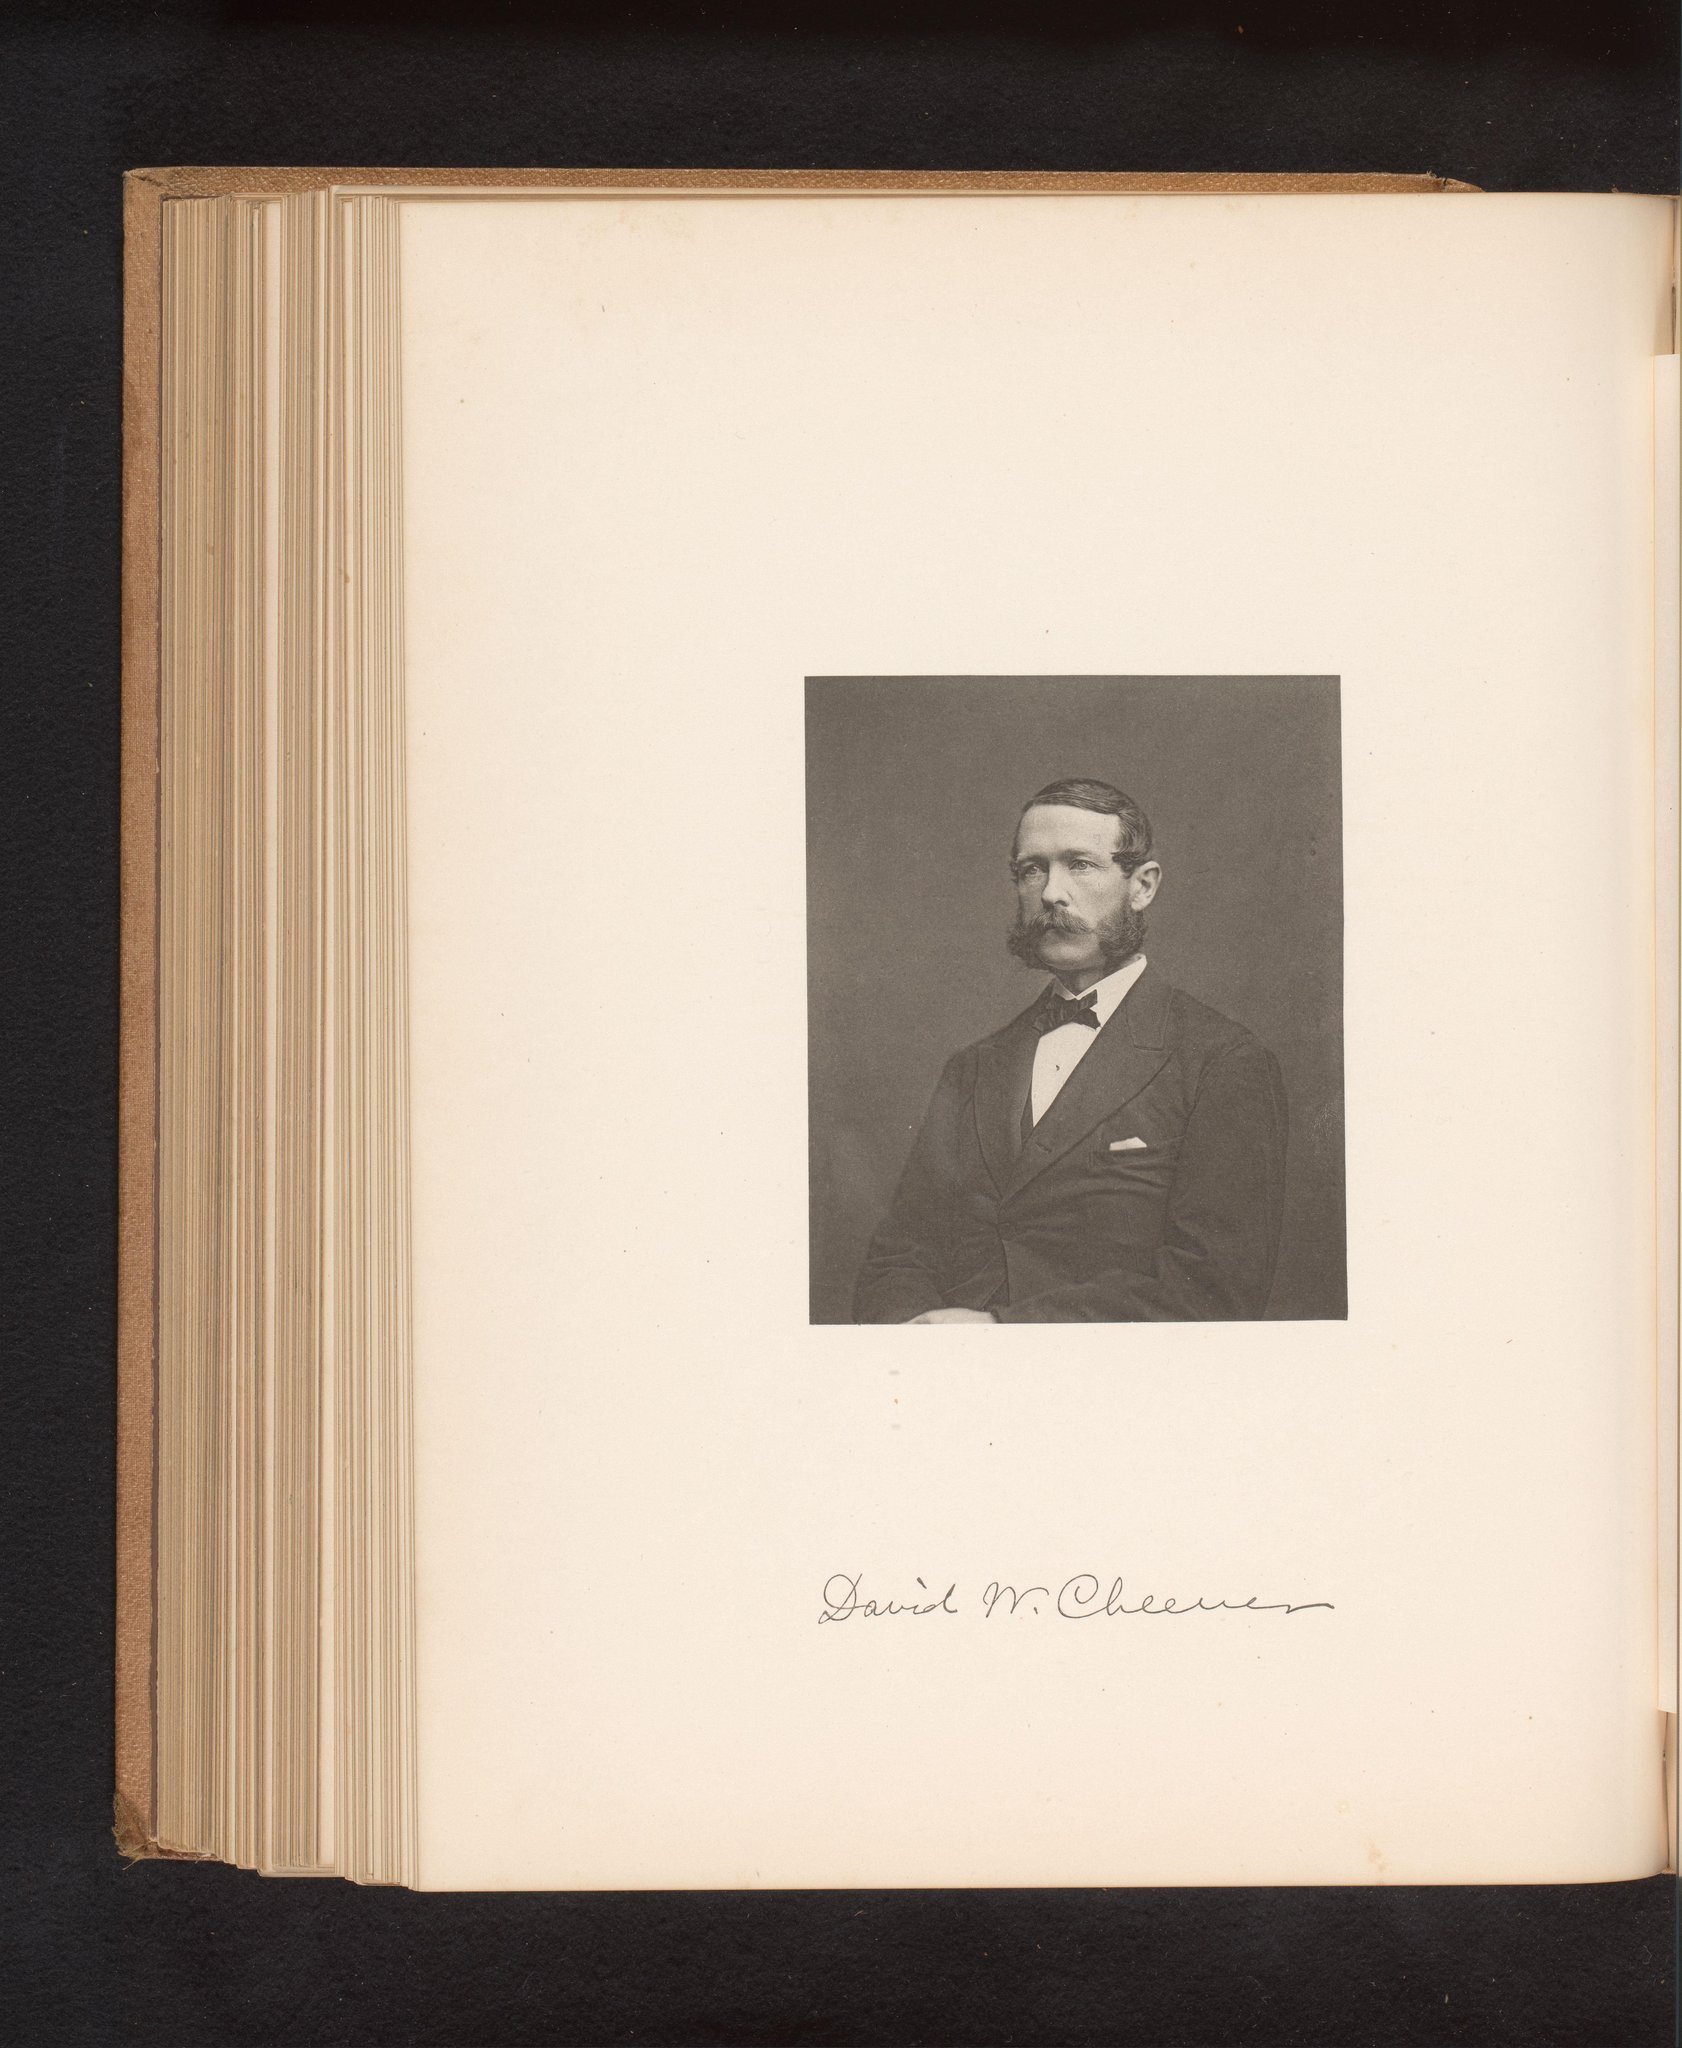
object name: photomechanical print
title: Portret van David Williams Cheever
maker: Anonymous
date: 1870-1875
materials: paper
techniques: photograph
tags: portsmouth, historical persons, physician, doctor, professor